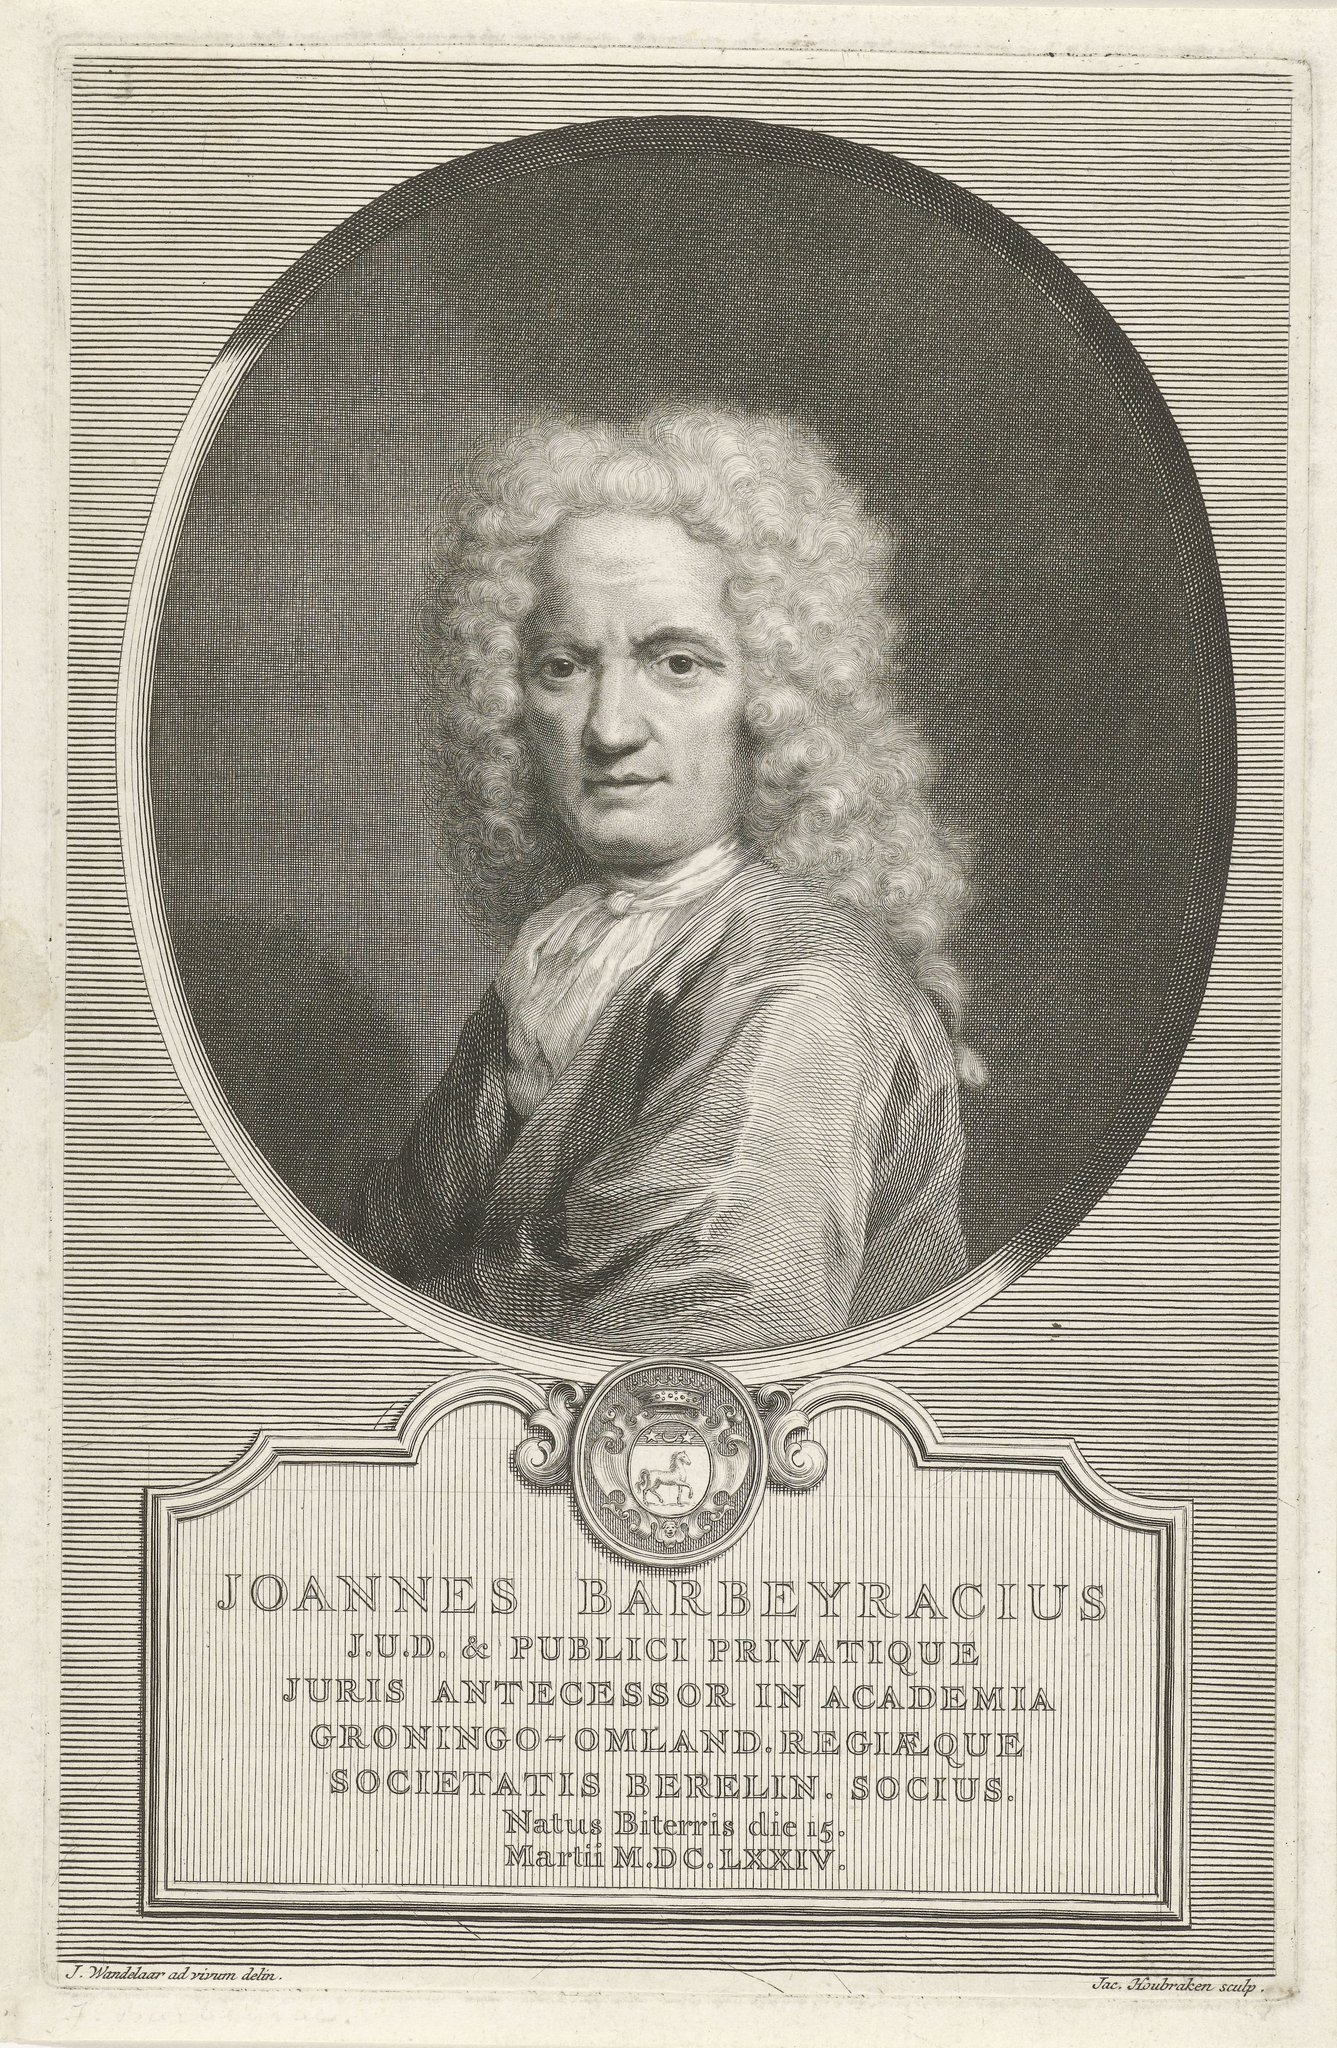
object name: print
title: Joannes Barbeyracius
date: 1717-1744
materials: paper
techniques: engraving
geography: amsterdam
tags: béziers, predikant, hoogleraar, jurist, jean barbeyrac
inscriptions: collector's mark: Lugt 2228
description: Buste naar links van Jean Barbeyrac in een ovaal. Onder het portret zijn wapen en naam en zes regels in het Latijn.